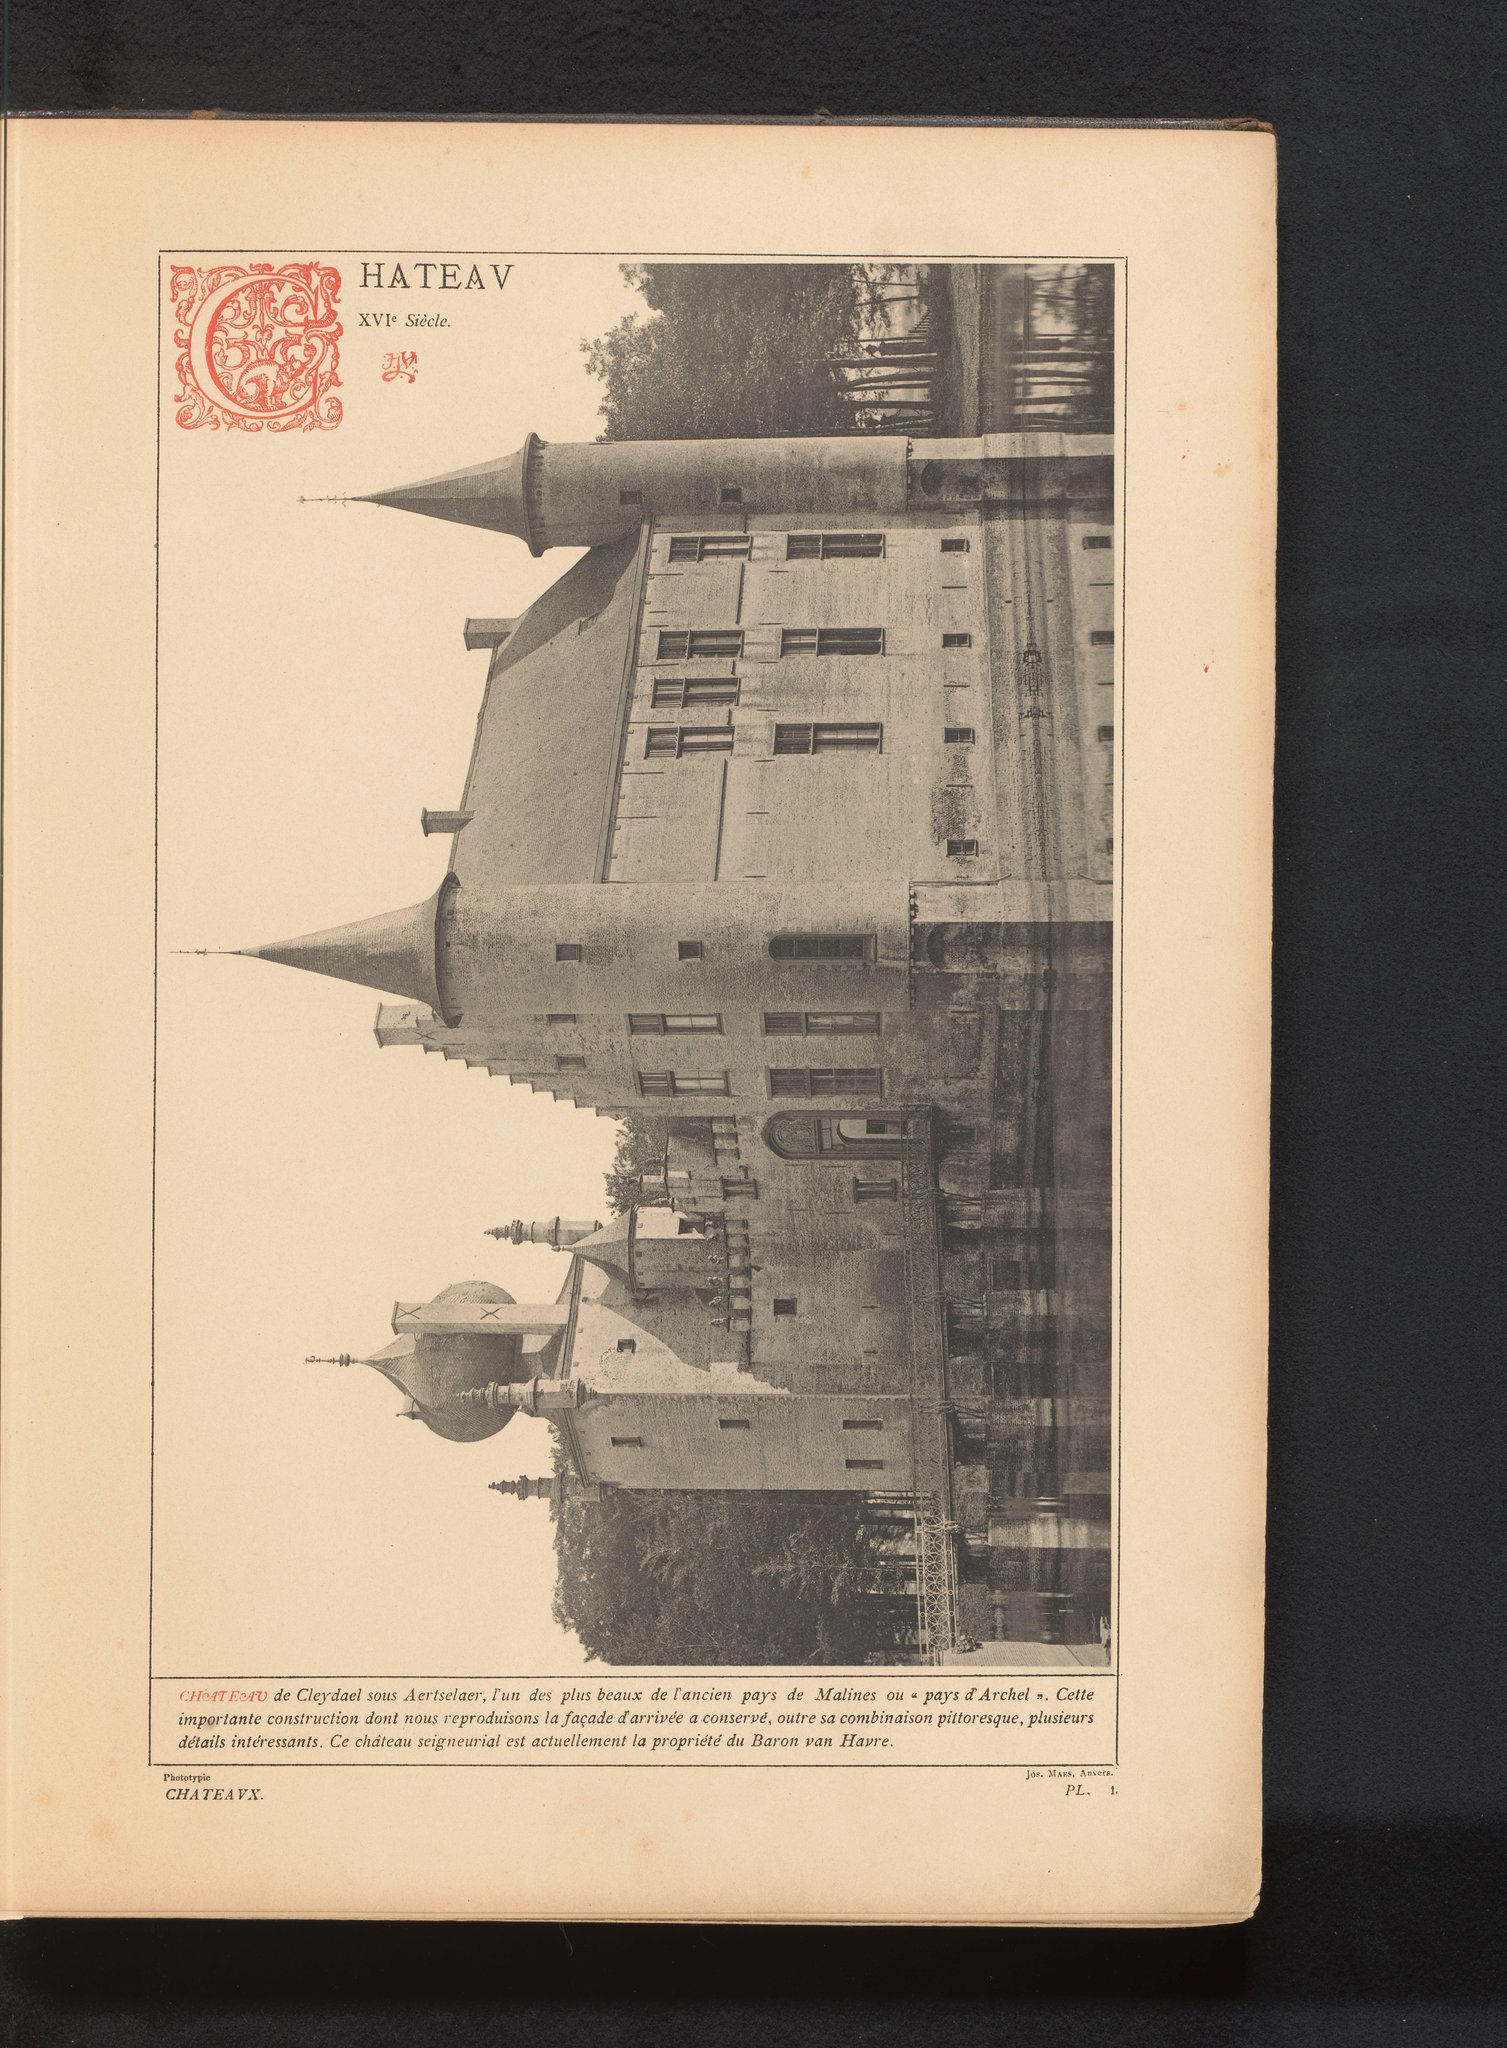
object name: page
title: Chateau, XVIe Siècle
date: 1881-1889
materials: paper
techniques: photograph, photolithography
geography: aartselaar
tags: castle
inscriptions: inscription: ‘CHATEAU de Cleydael (...)’, inscription: ‘CHATEAU. PL.1.’, monogram: ‘JJvY’